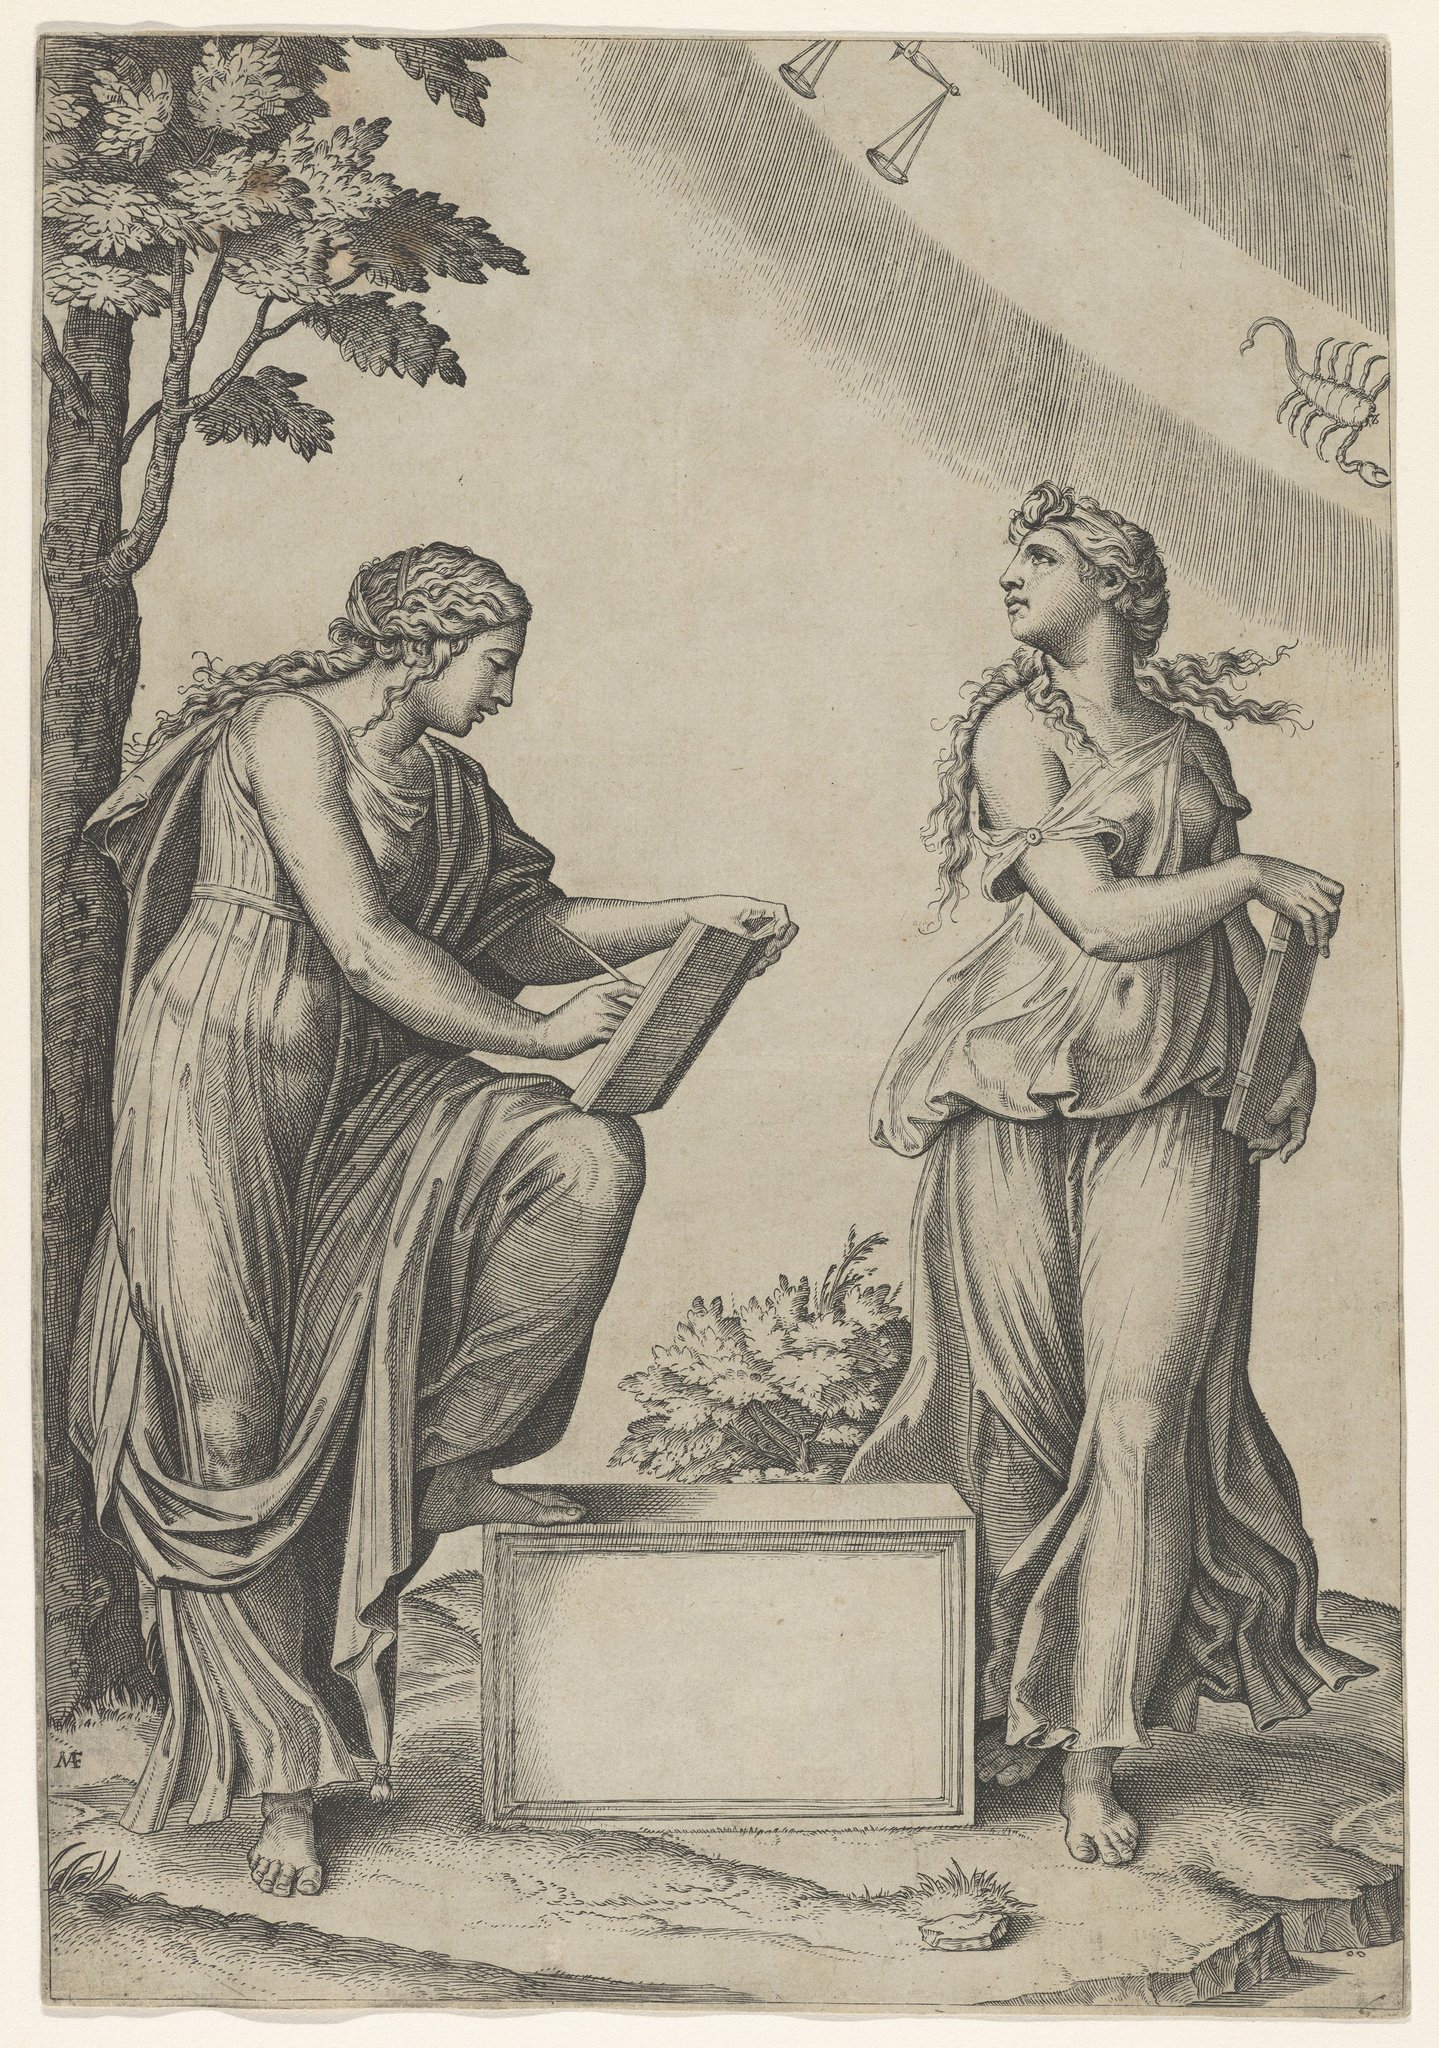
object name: print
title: Two women of the zodiac standing beneath the signs of Libra and Scorpio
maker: marcantonio raimondi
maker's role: artist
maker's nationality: italian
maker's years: 1475-1534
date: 1517-1520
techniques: engraving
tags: women,scorpions,zodiac,writing